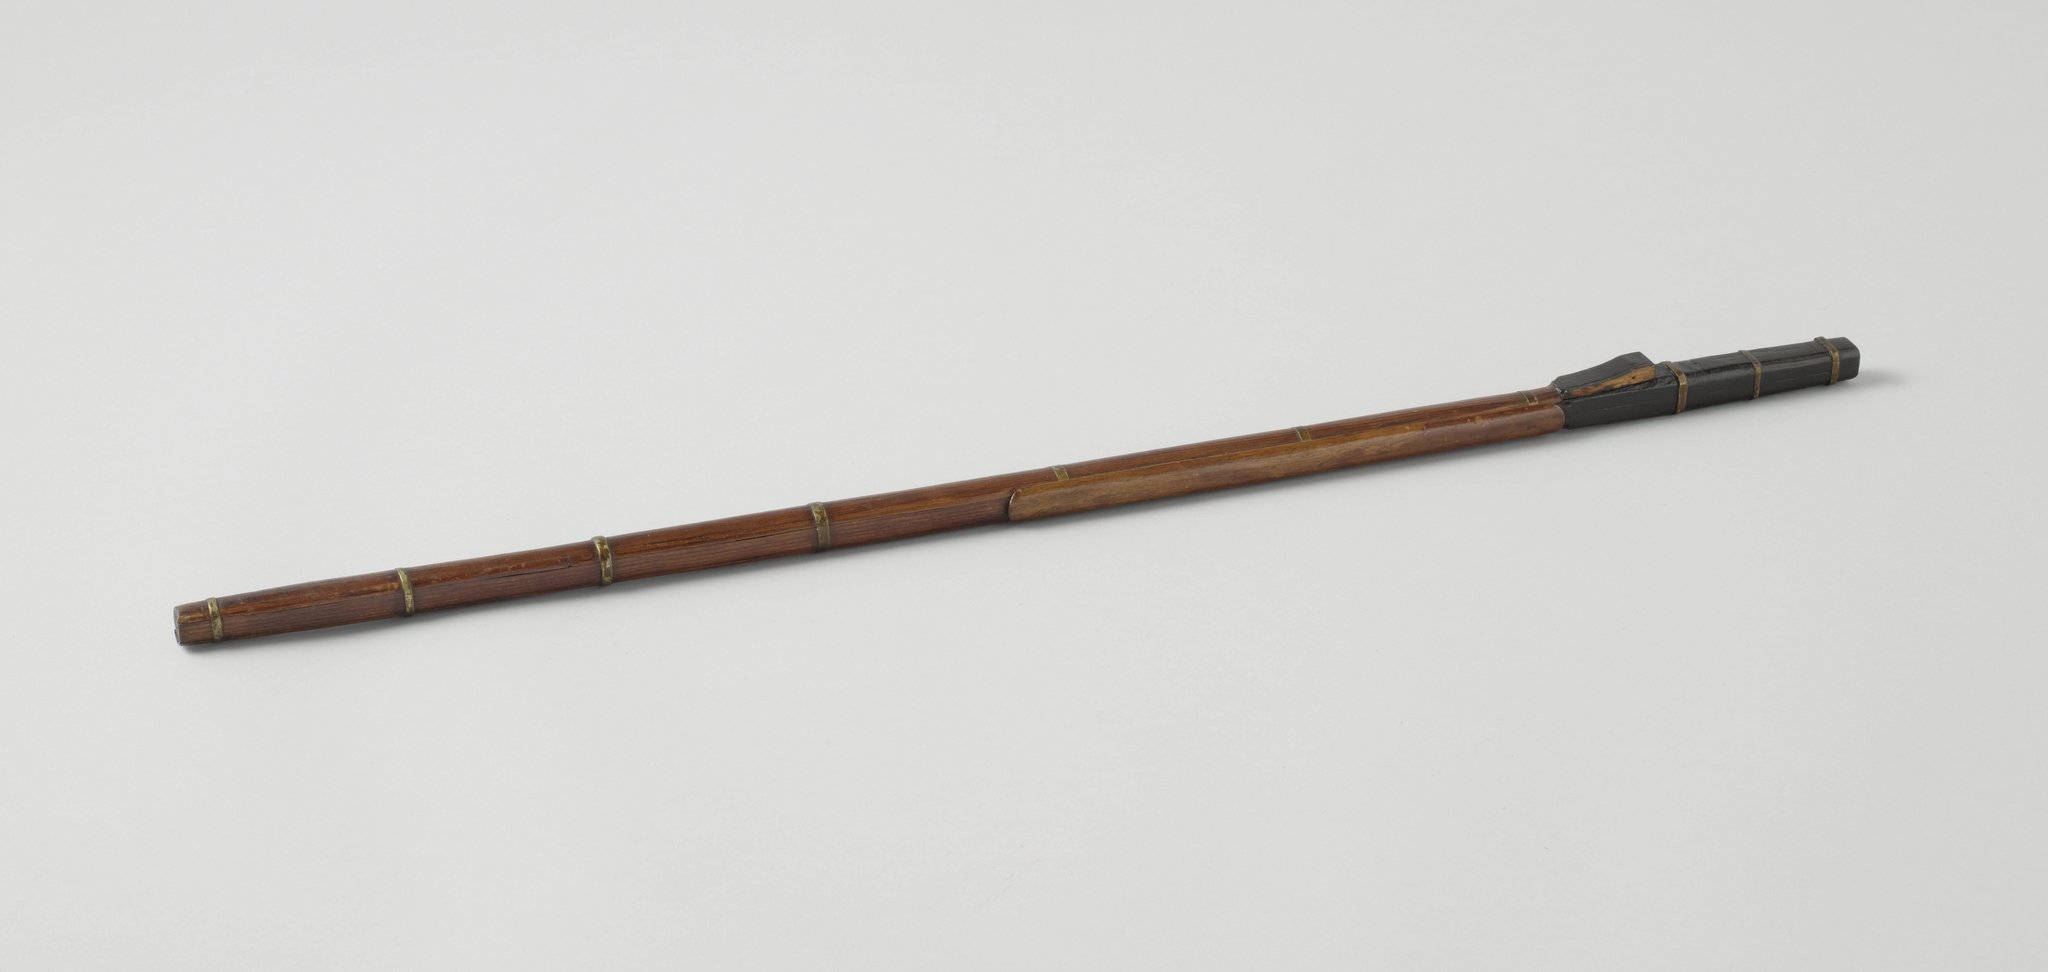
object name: demonstration model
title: Model of a Made Mast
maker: Anonymous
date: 1780-1840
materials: brass, wood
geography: netherlands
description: Ronde mast met vierkante top, hommer met oren en rijschaal. De mast zelf bestaat uit zes delen: twee zware, een voor en een achter, vormen de mastkoning, binnenin met lassen verbonden; een brede wang aan weerszijden is eveneens met lassen aan de mastkoning zijn verbonden, en twee smalle wangen ronden het geheel af. De delen worden door kuipbanden bijeengehouden. De hommer is een verbreding van de brede wangen. Ter hoogte van de hommer wordt de mast vierkant. Voorop de mast is een rijschaal aangebracht.